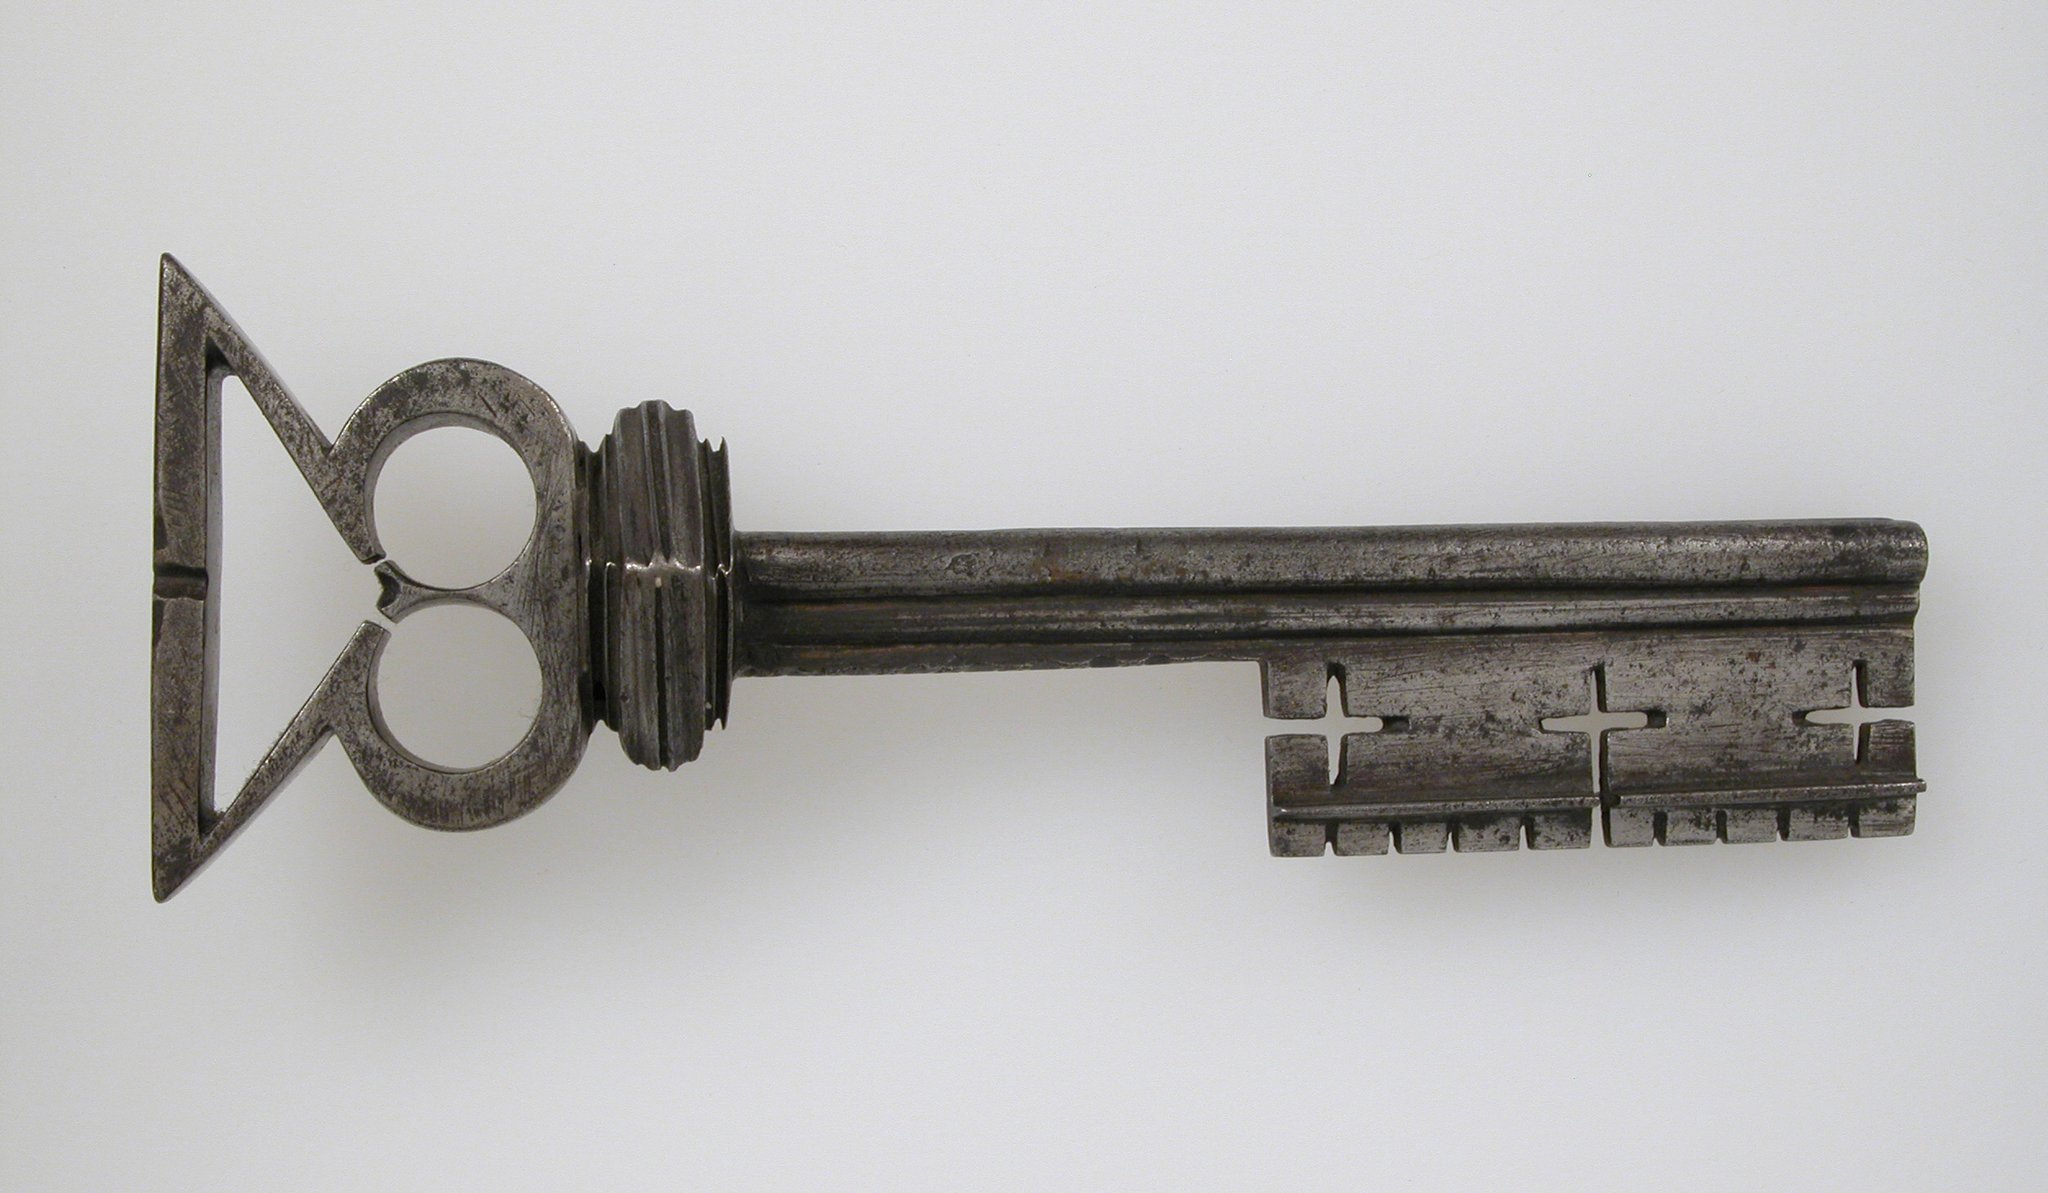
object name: key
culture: german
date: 1401-1500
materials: iron